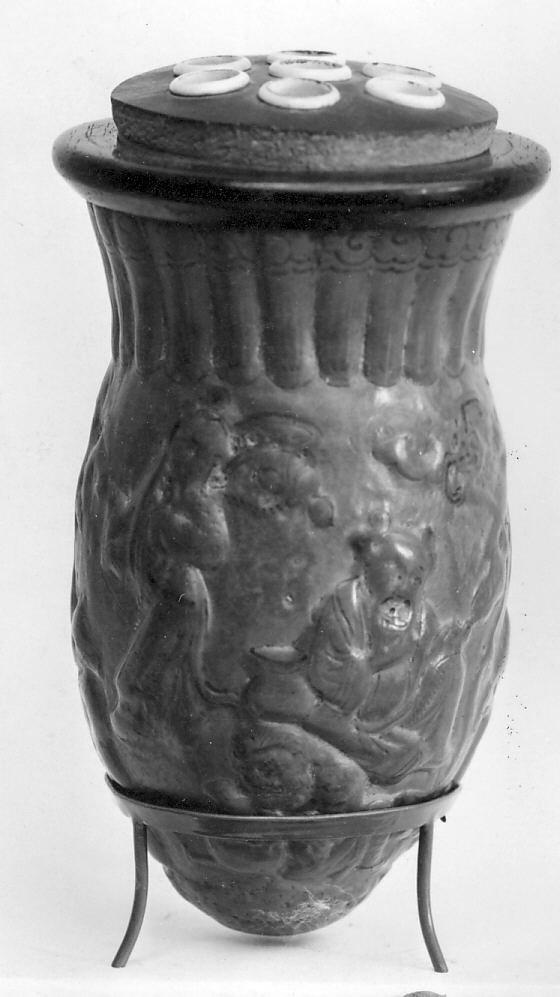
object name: cricket cage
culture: chinese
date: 1701-1900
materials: ivory, wood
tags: men